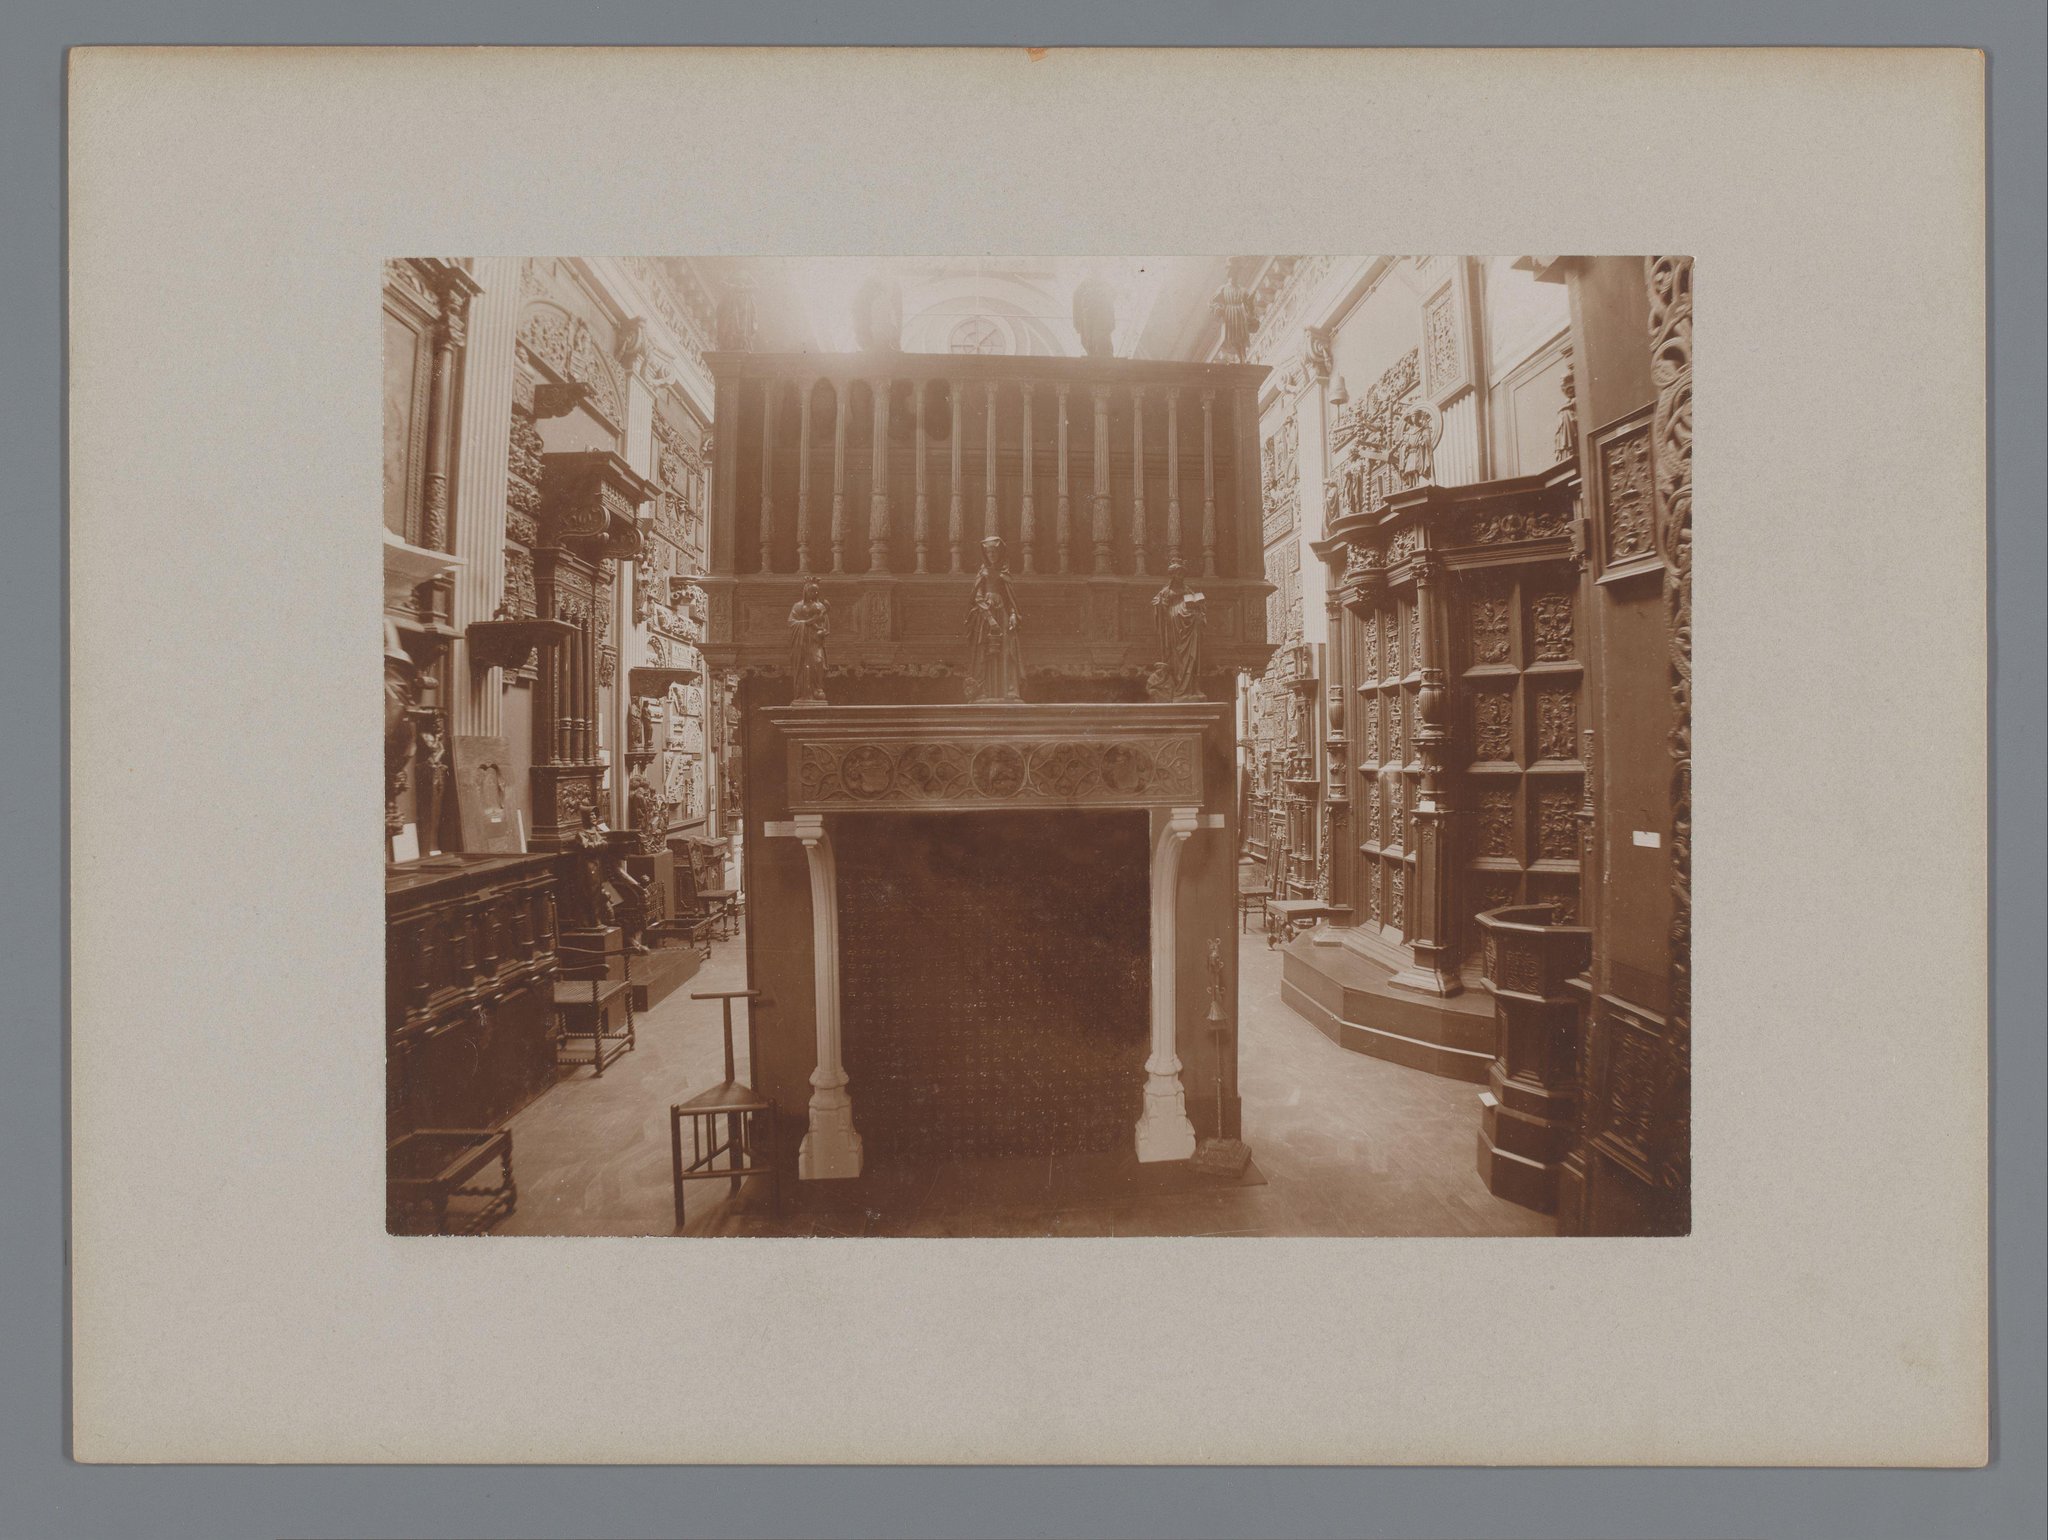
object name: photograph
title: Gezicht op een hal met een schouw en reliëfs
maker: johann pörtzgen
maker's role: fotograaf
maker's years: 1857-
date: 1890-1900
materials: cardboard, photographic support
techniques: collodion silver print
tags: open hearth, fire-place, ornamenting, decorating ~ applied arts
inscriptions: workshop stamp: ‘J. Pörtzgen/ Photograaf/ Koningstraat 38/ Haarlem’, collector's mark: ‘Museum van Kunst-Nijverheid Haarlem’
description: Dit albumblad maakt deel uit van een omslag met 6 bladen.